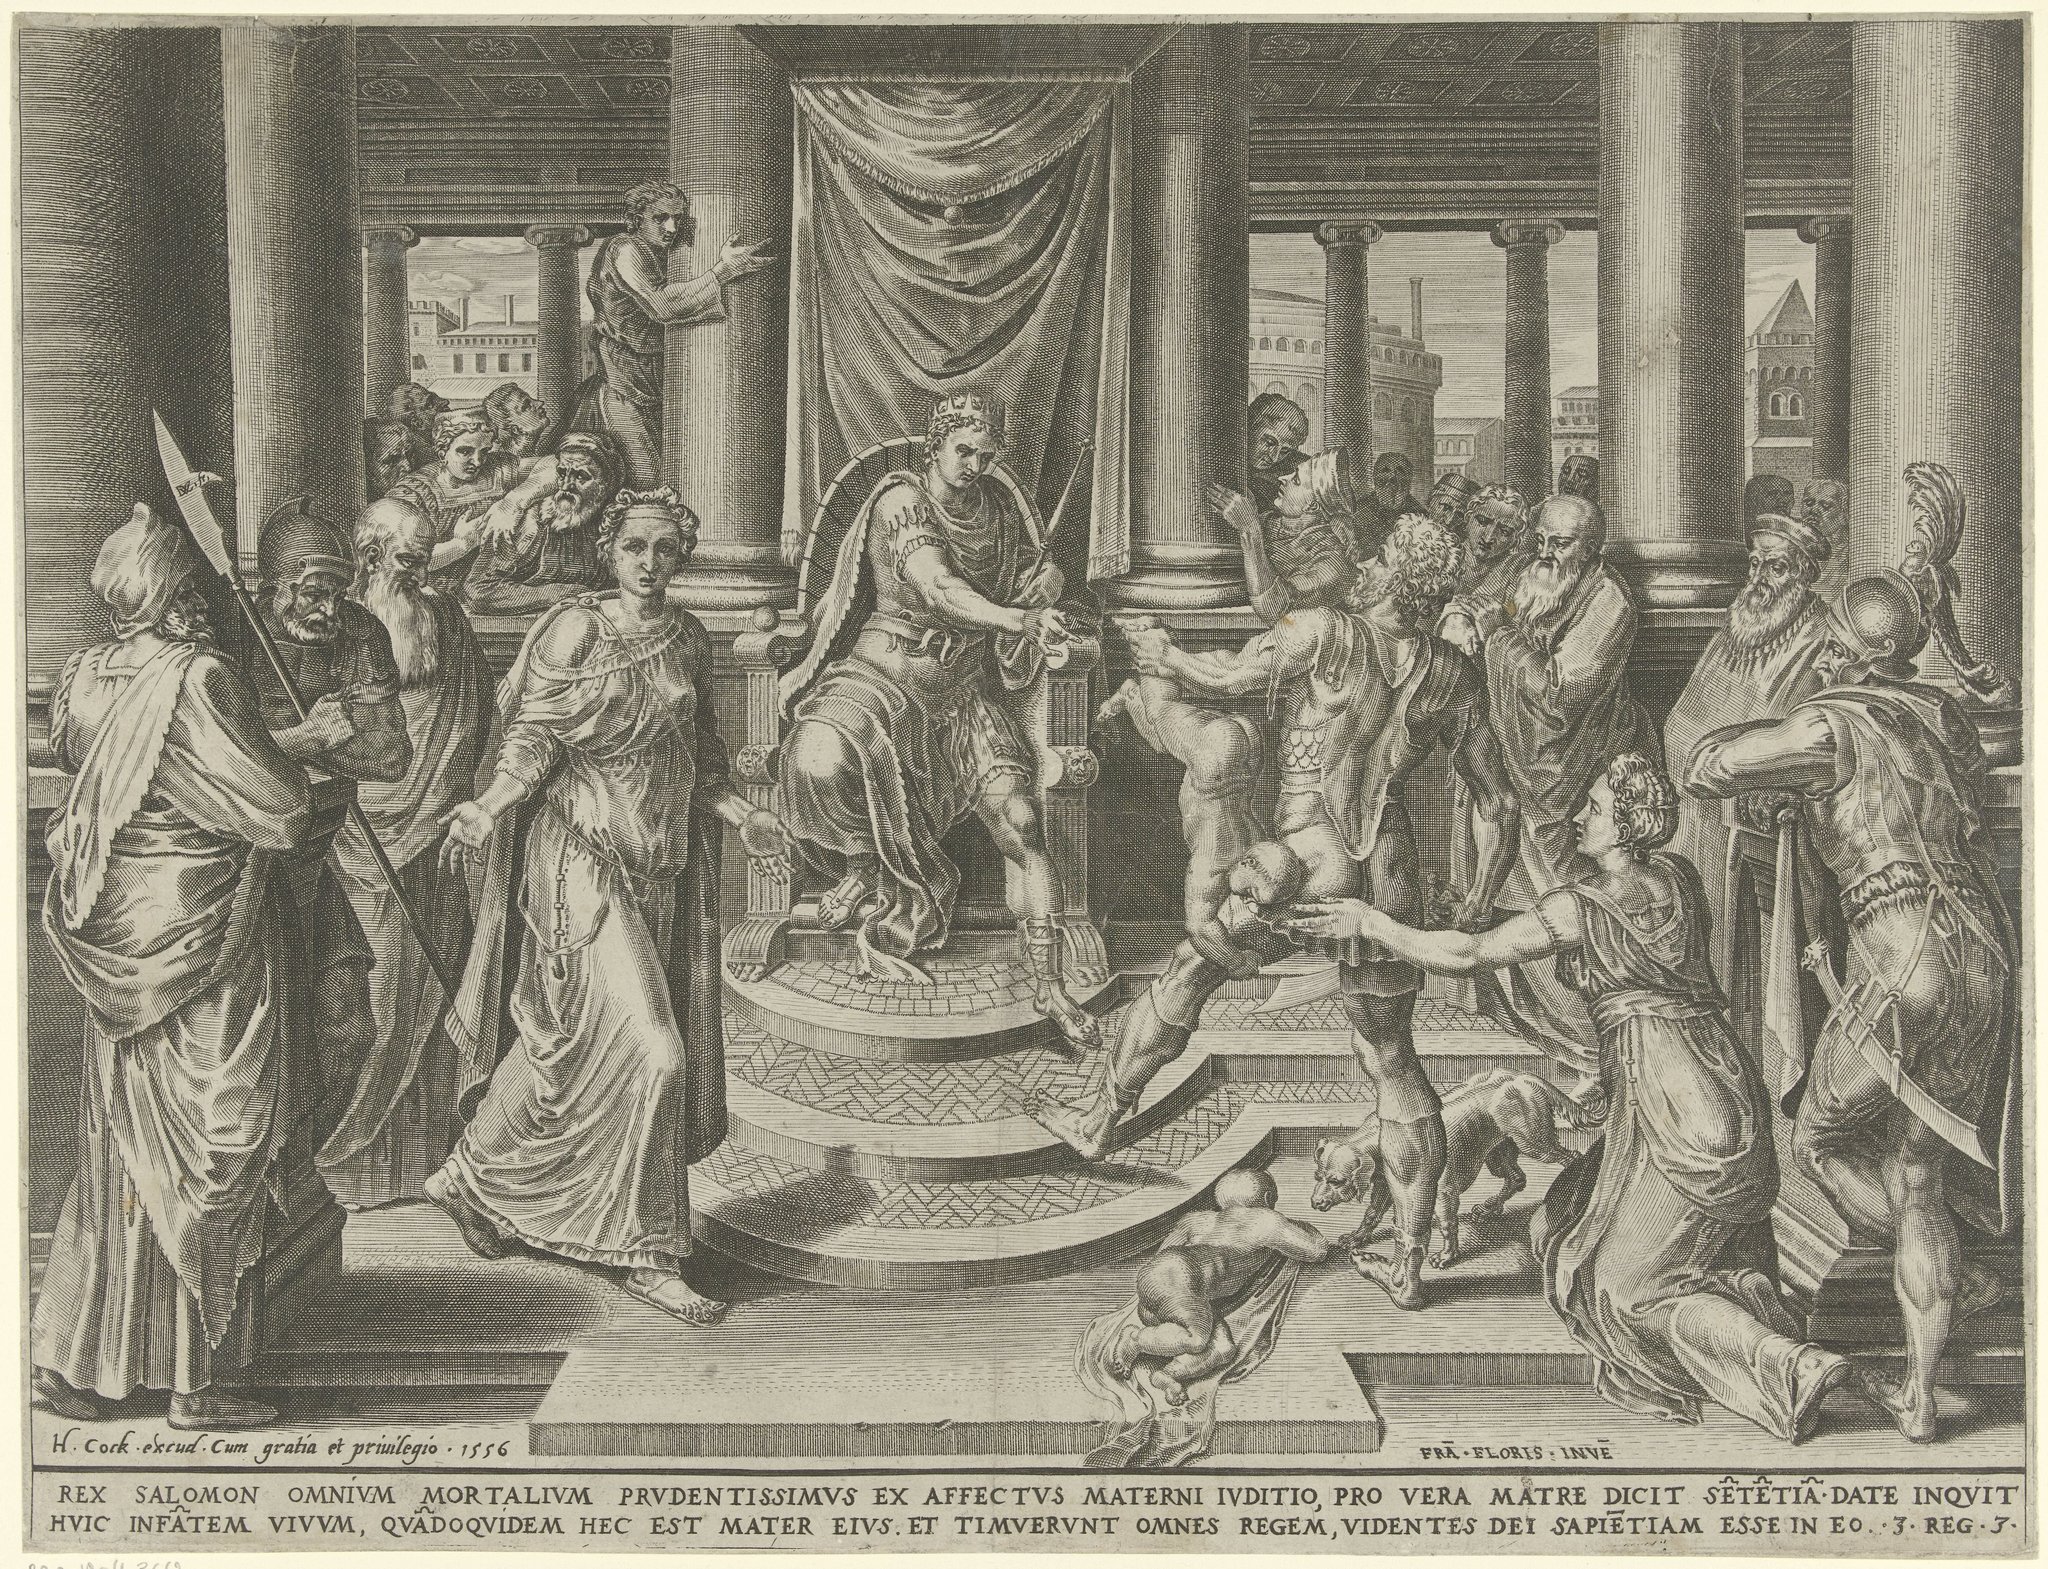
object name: print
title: Oordeel van Salomo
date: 1556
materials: paper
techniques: engraving, etching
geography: antwerp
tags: the judgement of solomon (1 kings 3:16-28)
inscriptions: date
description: Salomo zit op zijn troon en beveelt een van zijn soldaten het betwiste kind in tweeën te hakken. Links van de troon smeekt een van de moeders smeekt om genade en bewijst zo dat zij de echte moeder is. De andere moeder (rechts) zit naast een dood kind, dat het hare was. De prent heeft een Latijns onderschrift.